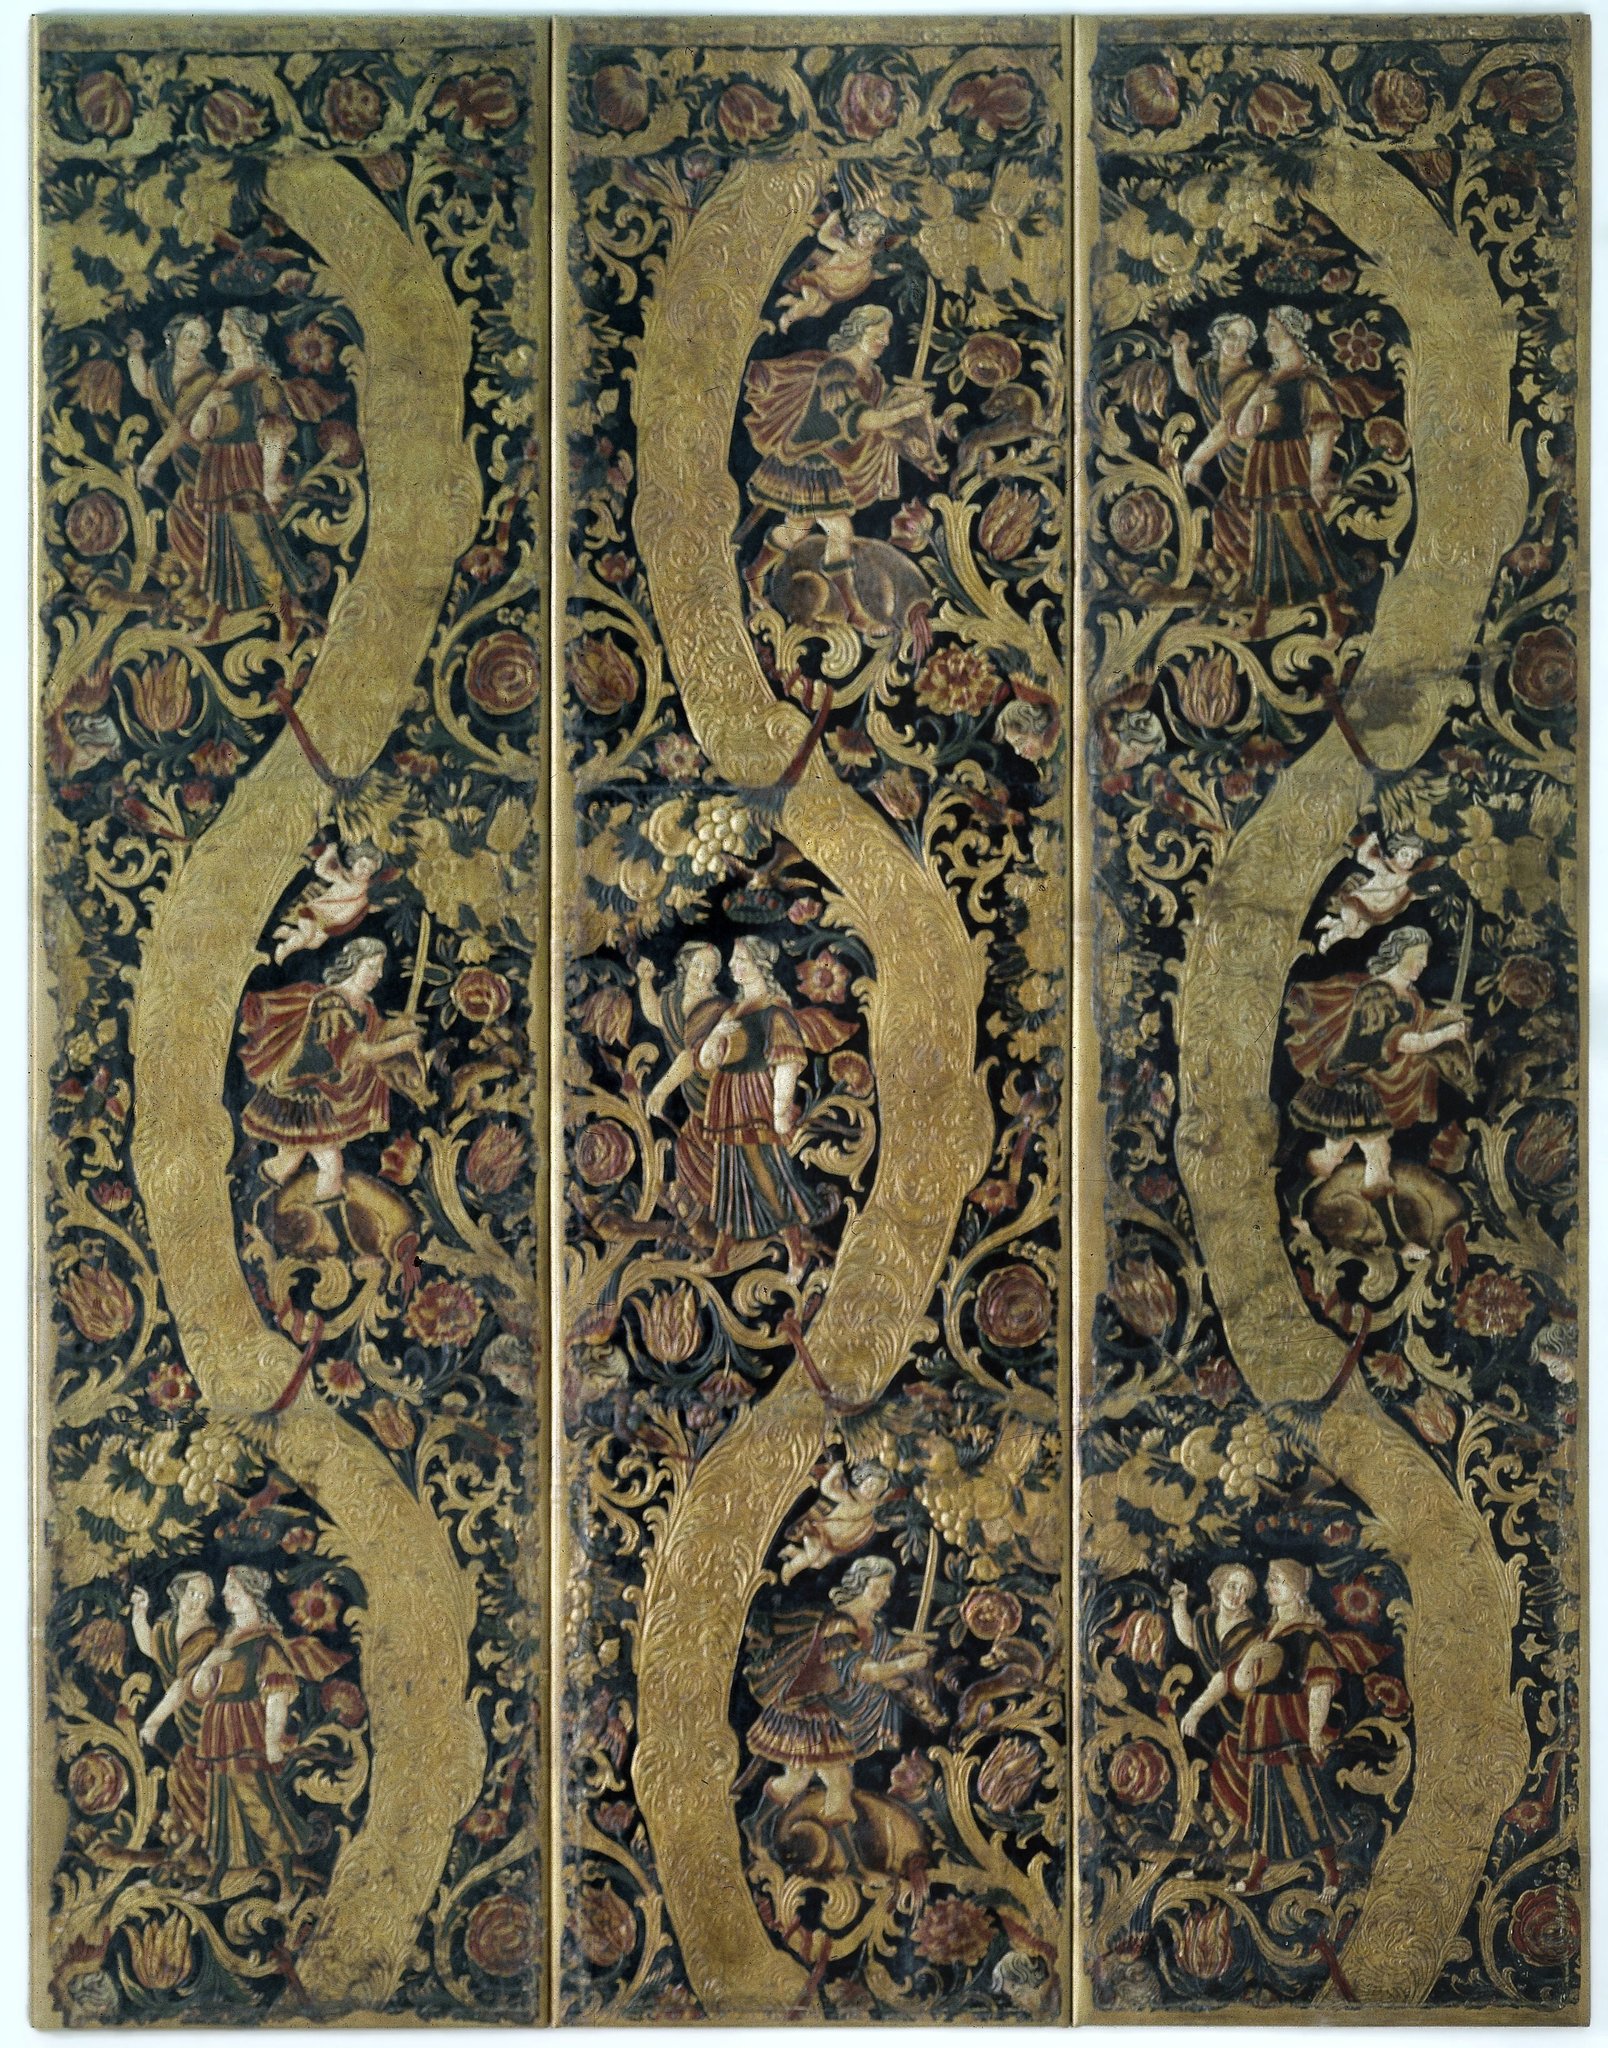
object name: vouwscherm, kamerscherm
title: Vijfbladig kamerscherm van gepolychromeerd goudleer met bloem-, vrucht- en bladranken en mythologische jachtvoorstelling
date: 1630-1650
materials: gilt leather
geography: amsterdam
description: Three-part screen. Polychrome leather. Depiction of Meleager and Atlanta. Northern Netherlands, probably Amsterdam, c. 1600 (screen assembled at recent date).